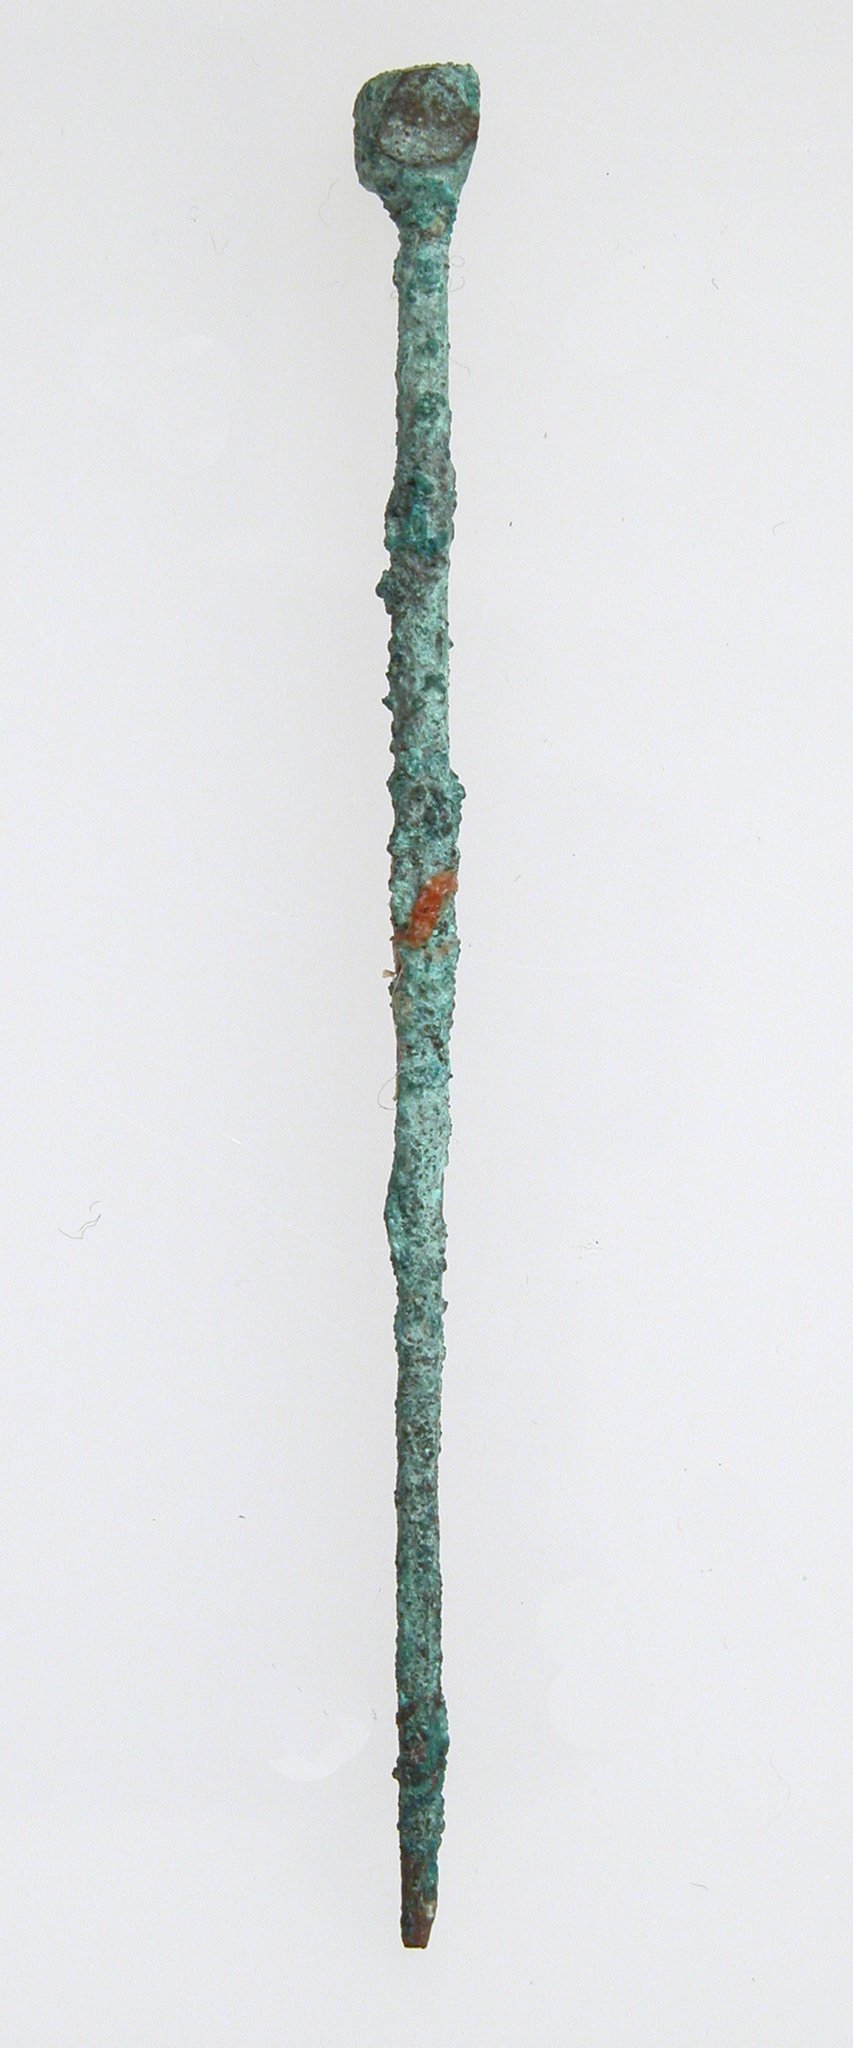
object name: hairpin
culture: roman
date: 200-500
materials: copper alloy